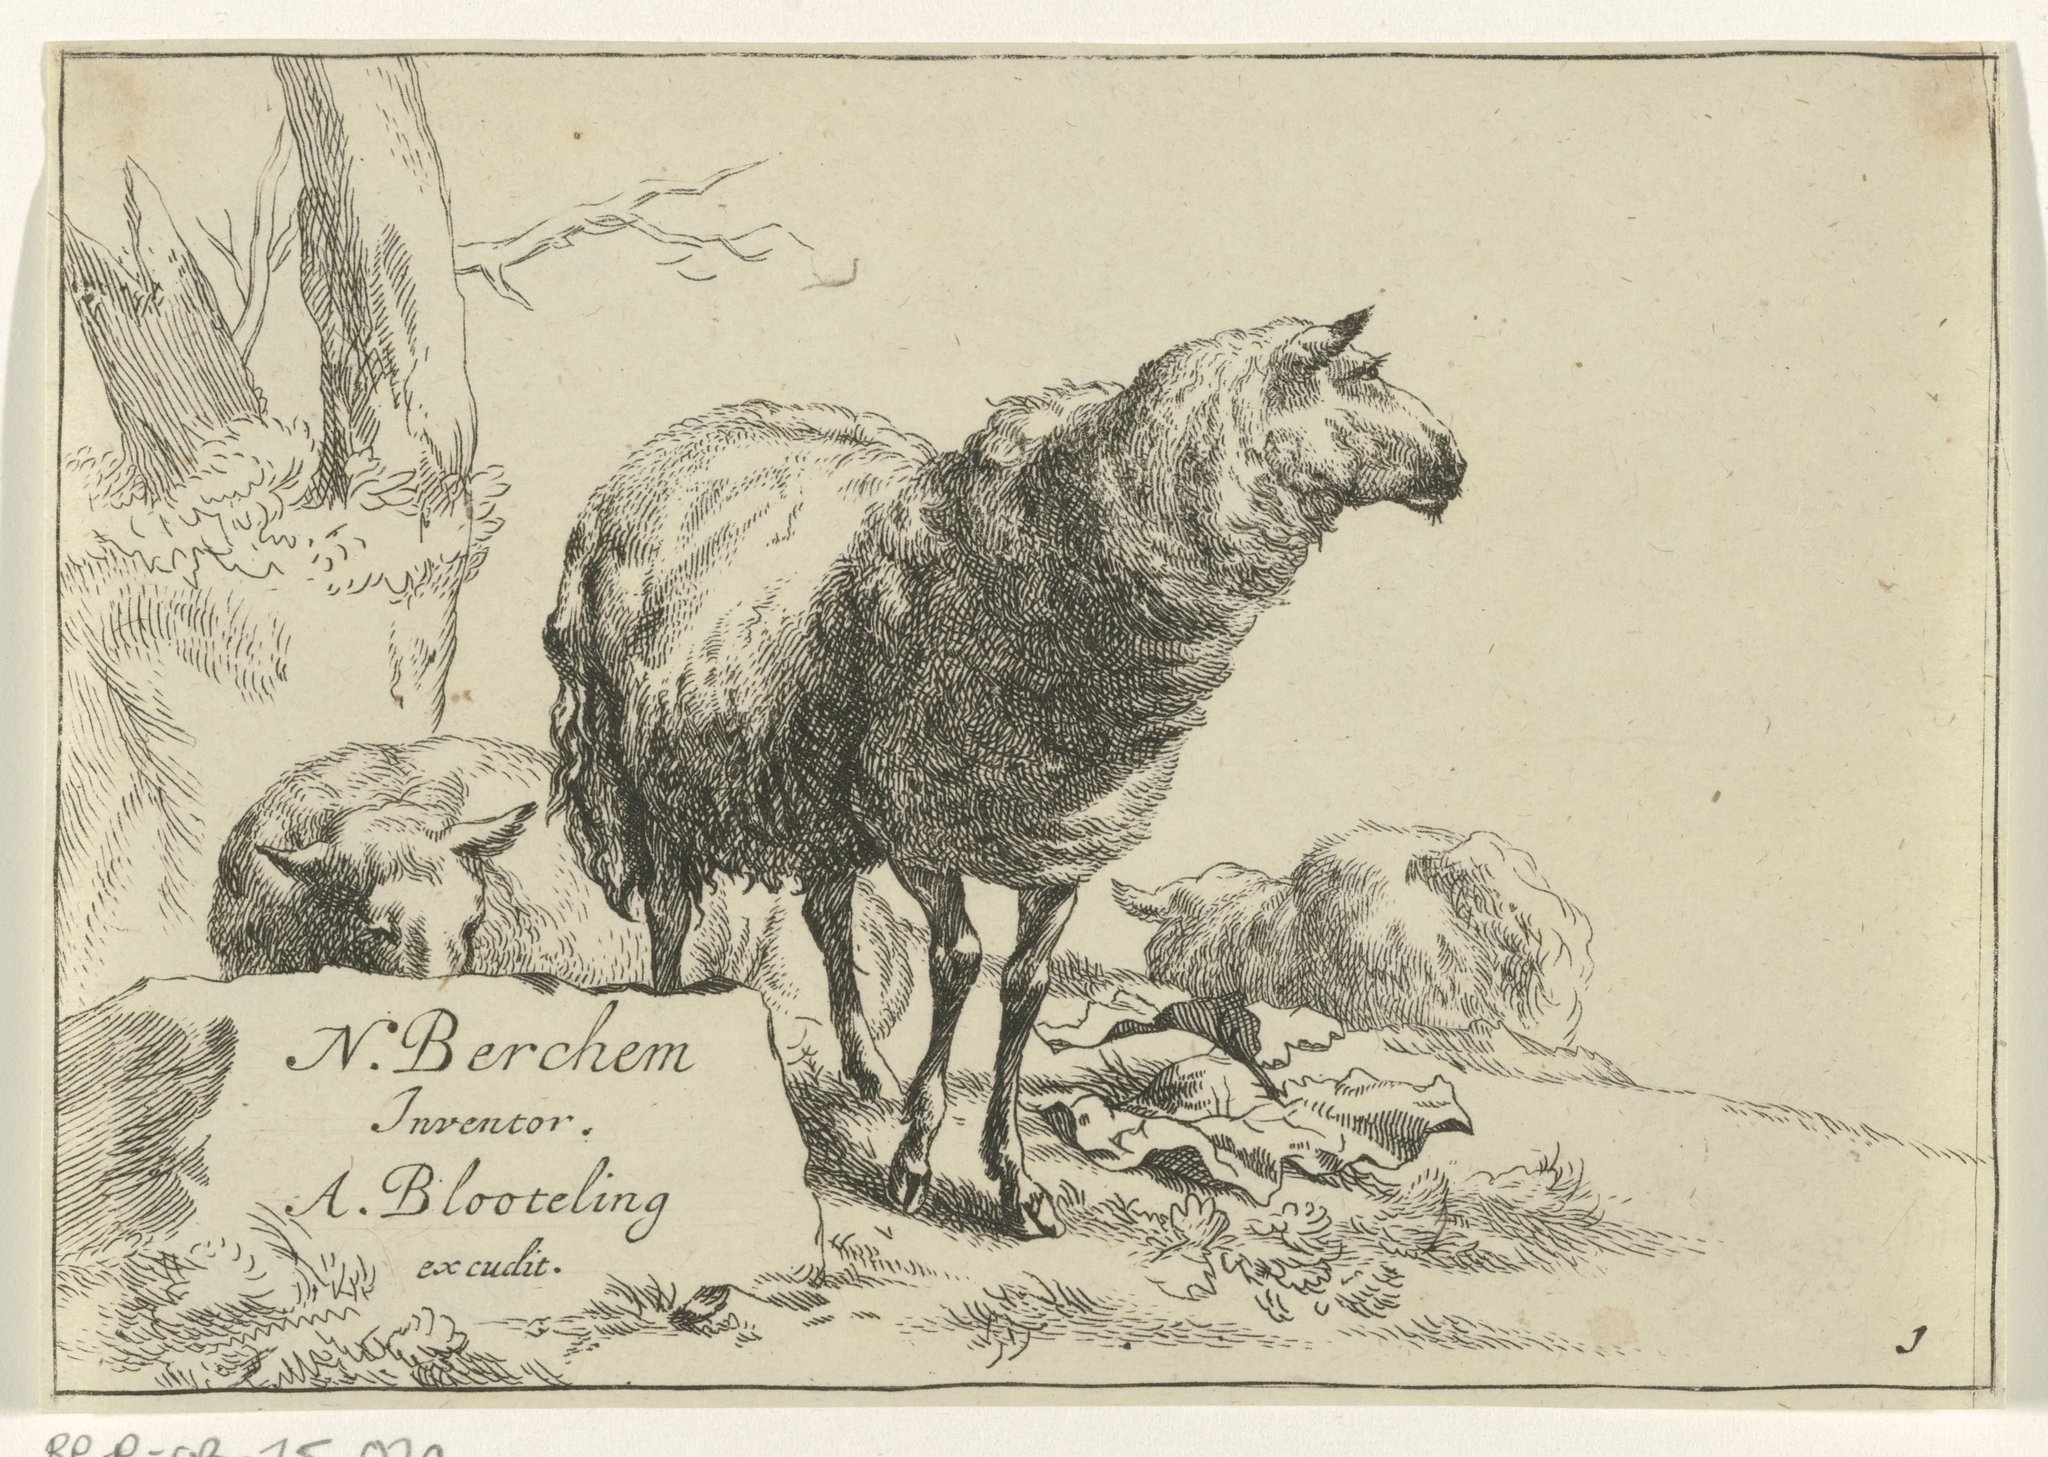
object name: print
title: Drie schapen bij een steen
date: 1655-1690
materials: paper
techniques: engraving, etching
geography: amsterdam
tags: sheep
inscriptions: collector's mark: Lugt 240